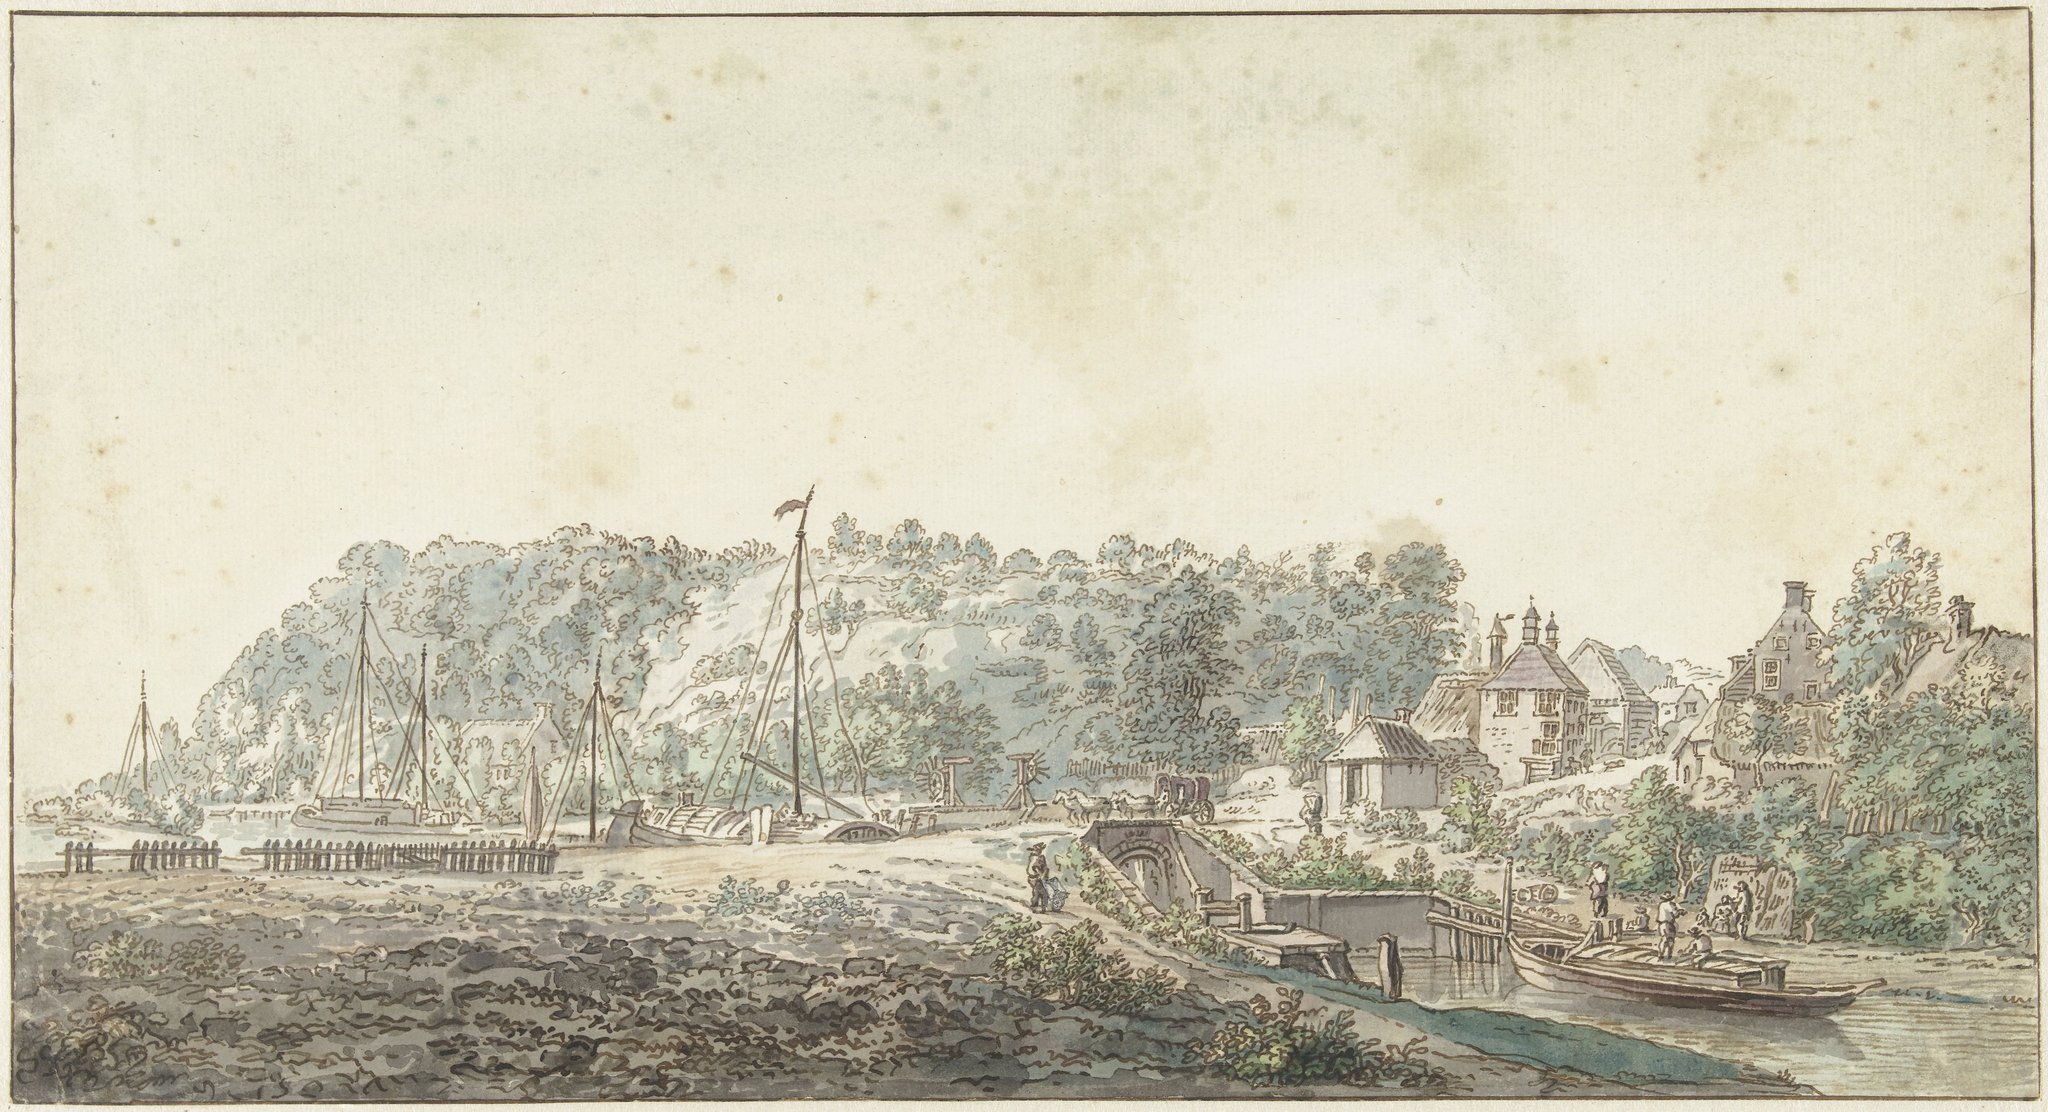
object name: watercolor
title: De sluis bij de Grebbe tussen Rhenen en Wageningen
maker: jacob van liender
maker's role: draughtsman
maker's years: 1696-1759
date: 1749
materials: ink, paper, watercolor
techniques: brush, pen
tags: sluice, weir